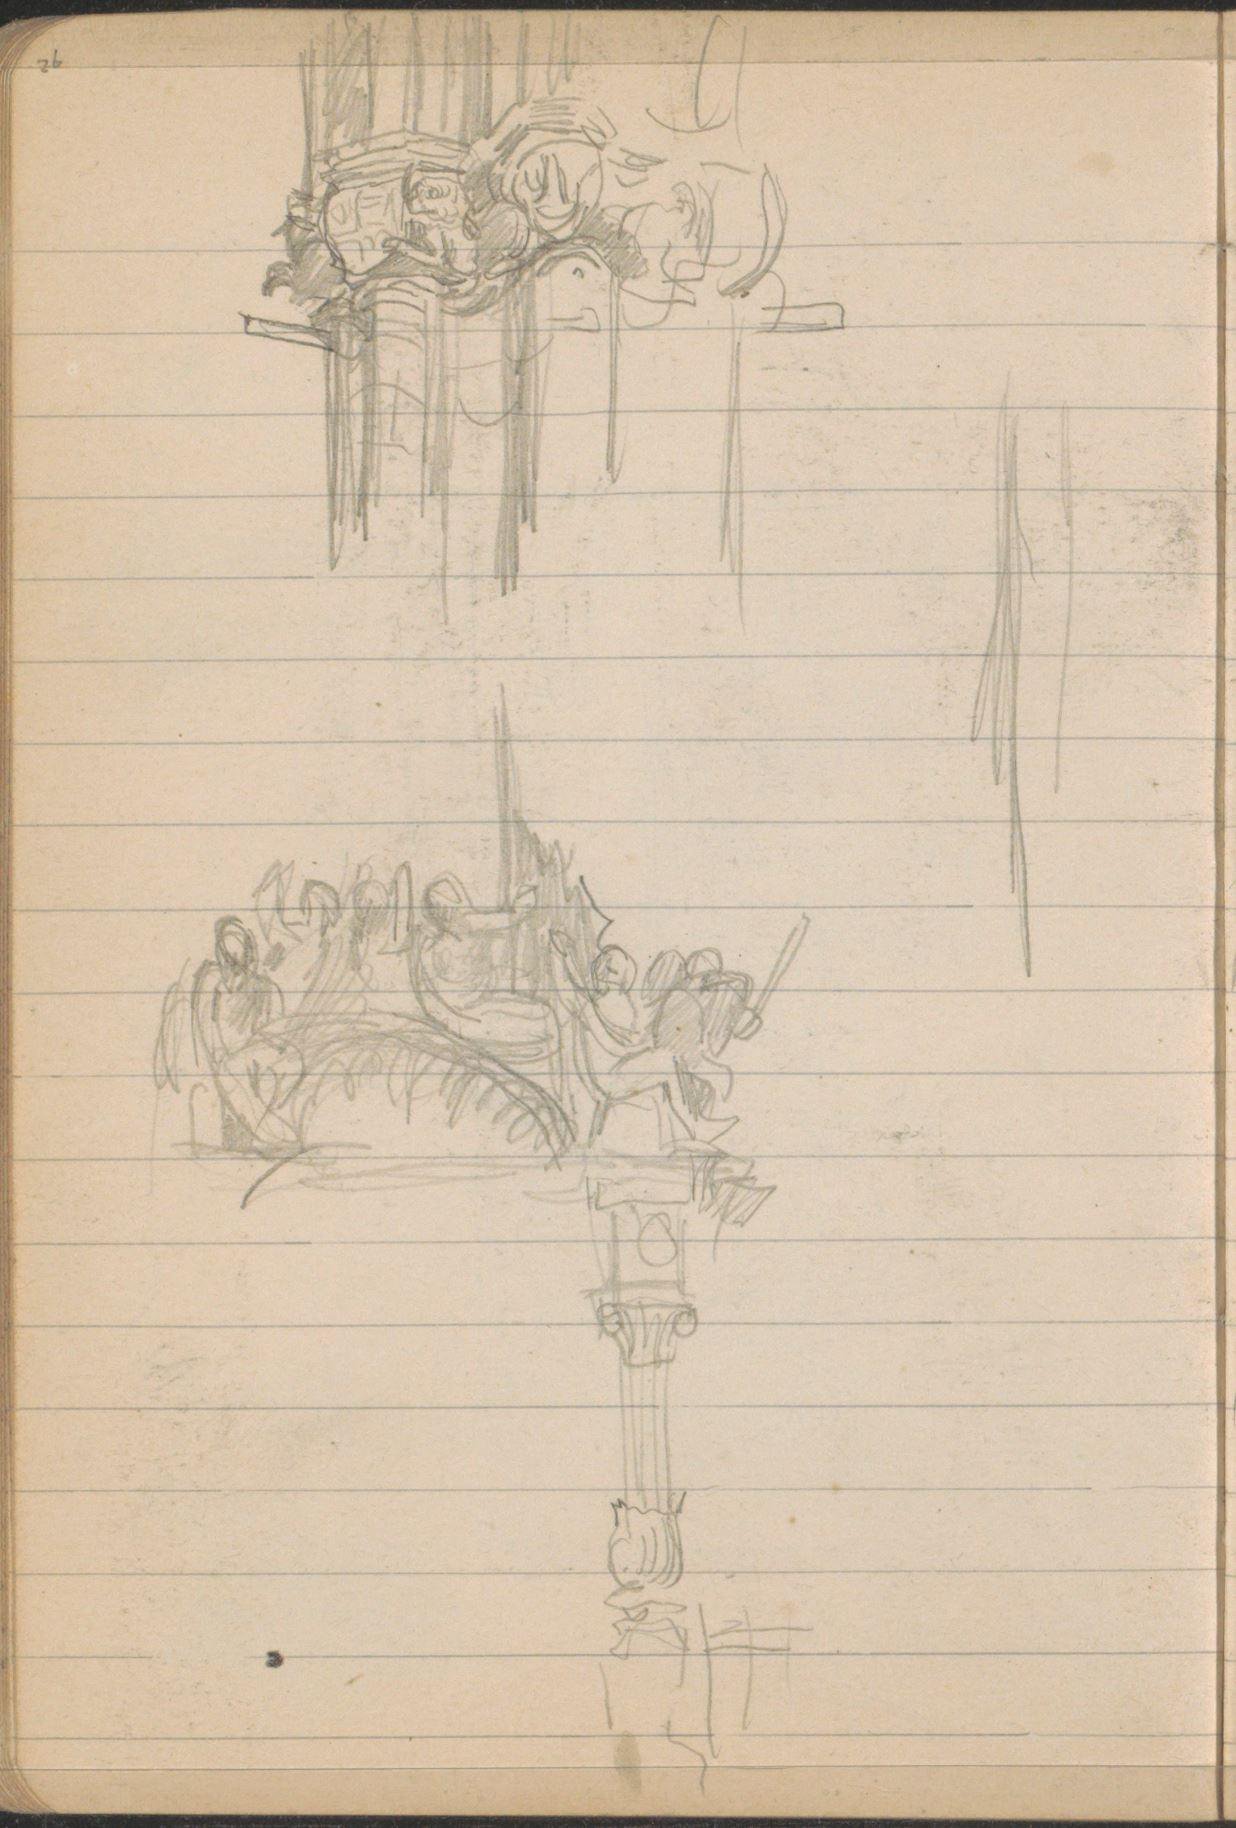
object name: sketchbook leaf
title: Zuilen en beeldhouwwerk van de La Seo kathedraal in Zaragoza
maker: marius bauer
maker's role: draughtsman, print maker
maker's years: 1867-1932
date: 1902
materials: pencil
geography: zaragoza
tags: column, pillar ~ architecture, sculpture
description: Pagina 26 uit een schetsboek met 50 bladen.